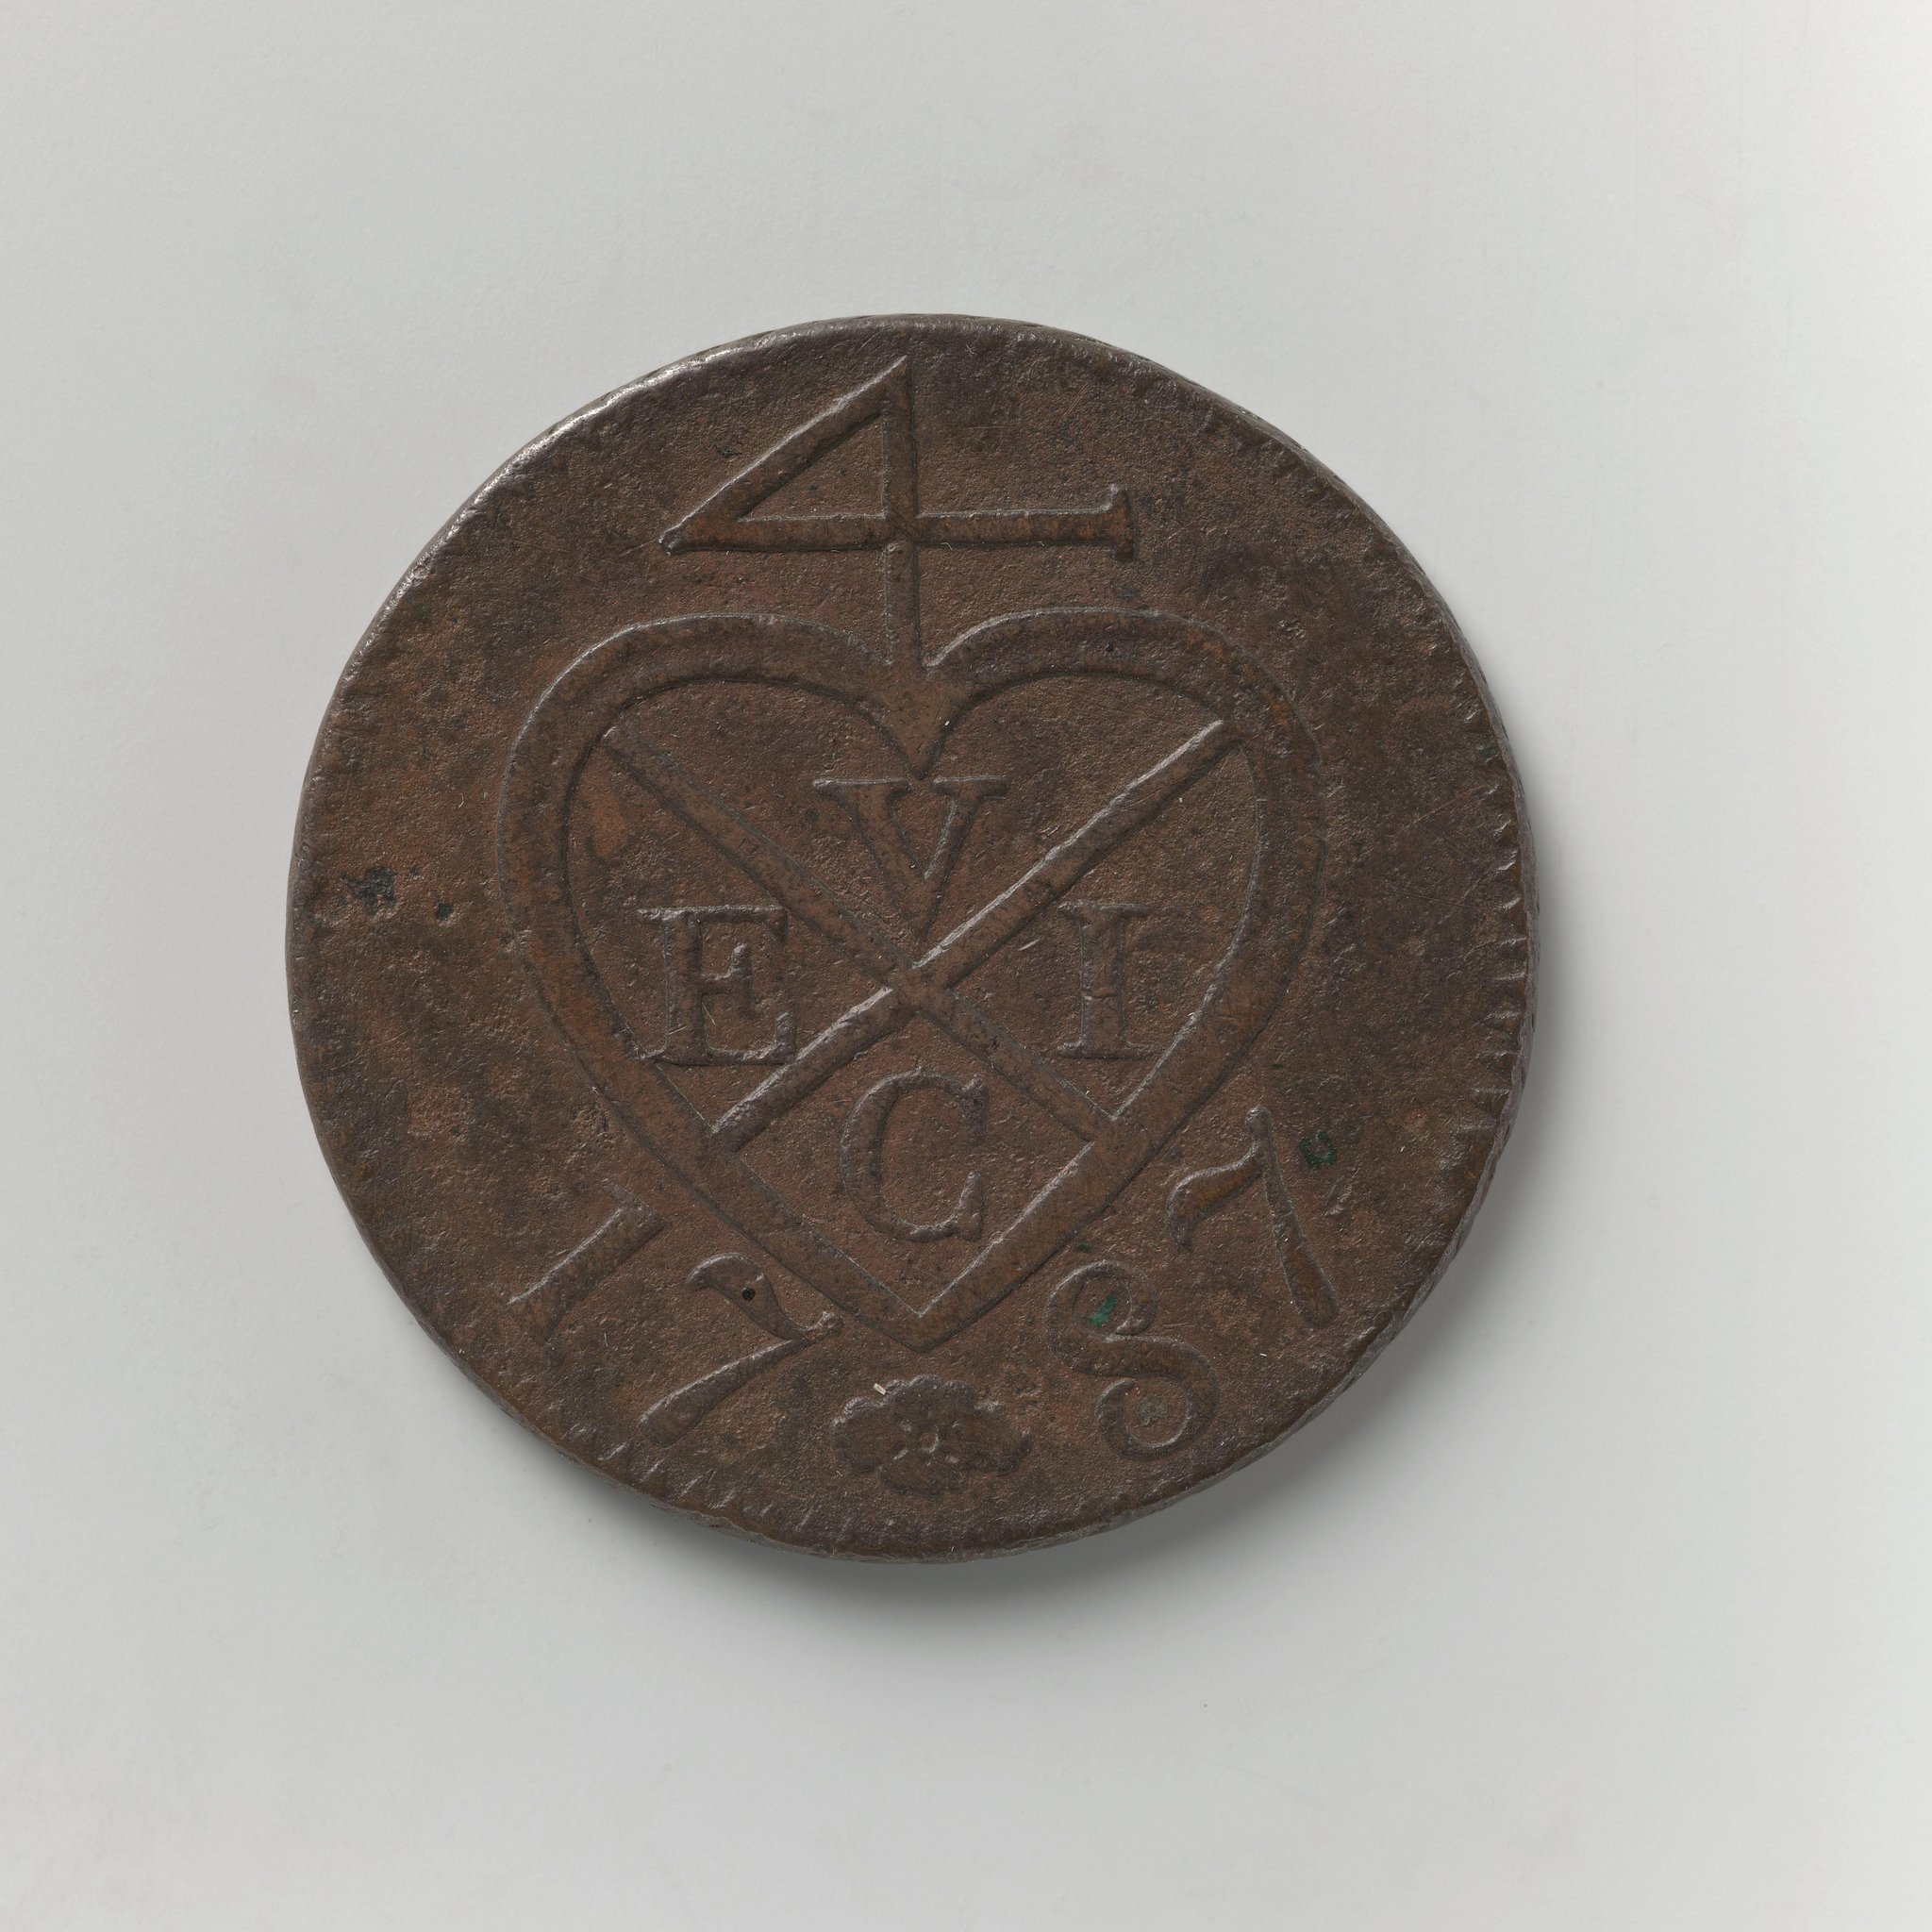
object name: coin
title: 3 kepengs van Engels Sumatra, Benkoelen,1787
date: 1787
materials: copper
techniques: striking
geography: birmingham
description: Koperen munt. Voorzijde: monogram van de Engelse Oostindische Compagnie, waaromheen jaartal. Keerzijde: op een regel in het Maleis waarde-aanduiding: tiga kepeng in Arabische lettertekens. Daarboven waarde-aanduiding: 3 in Arabische cijfers en daaronder jaartal in Islamitische tijdsrekeningen Arabische cijfers. Kabelrand.